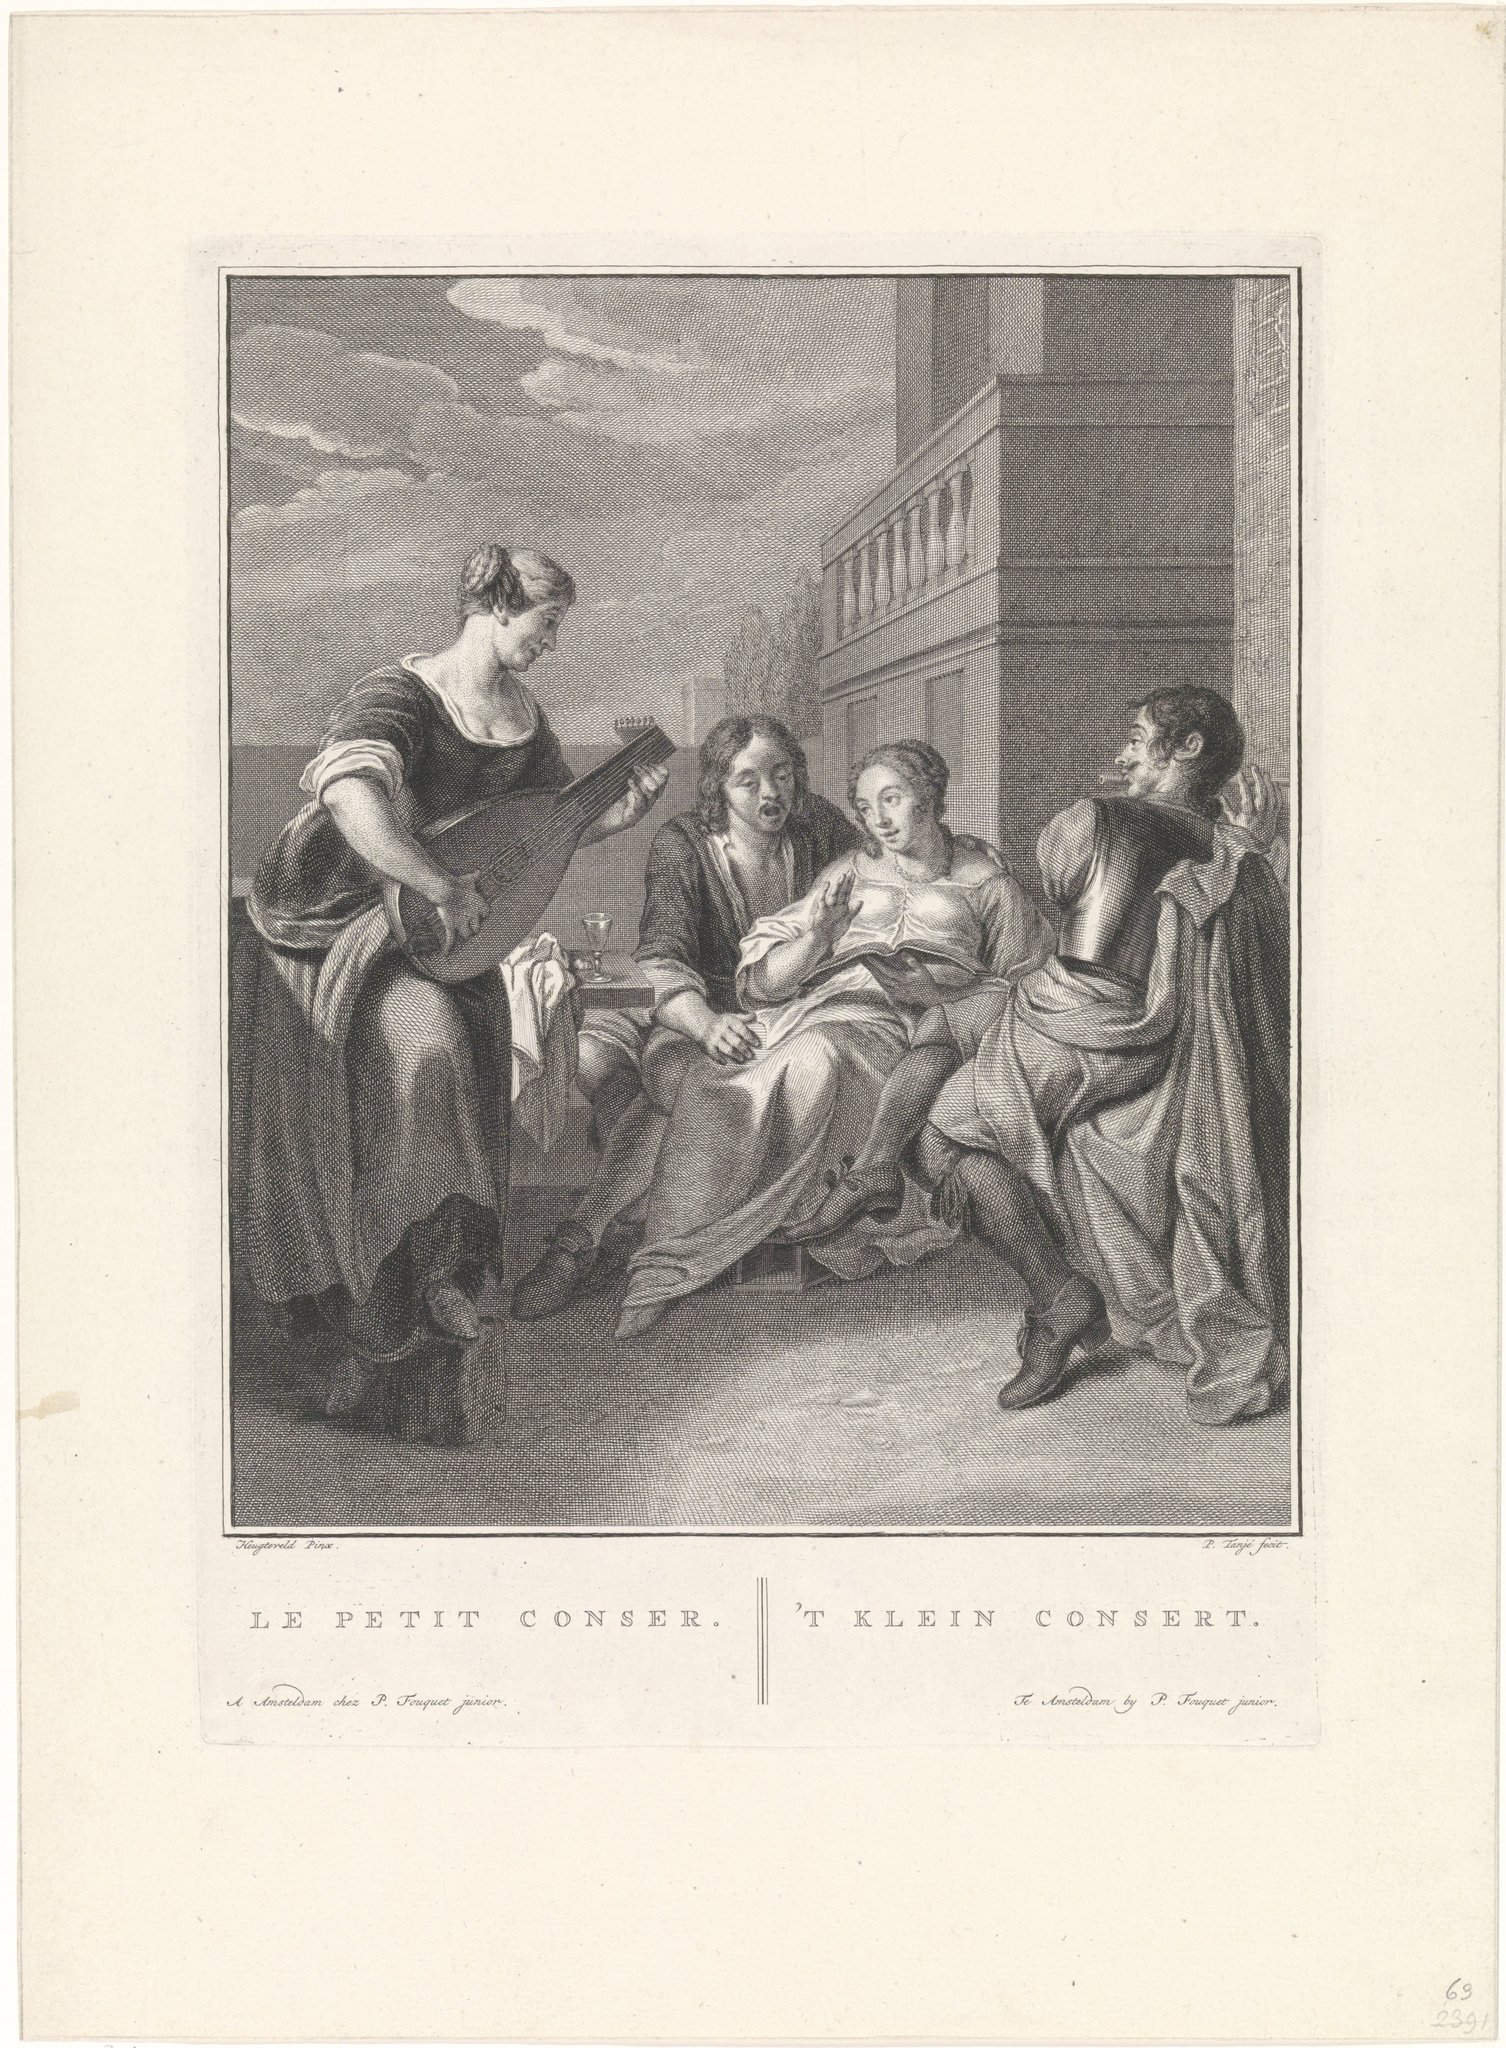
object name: print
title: Le petit conser / 't Klein concert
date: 1760-1761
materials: paper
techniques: engraving, etching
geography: amsterdam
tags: instrumental and vocal music together, transverse flute, lute, and special forms of lute, e.g.: theorbo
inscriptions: collector's mark: Lugt 240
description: Op een terras in de buitenlucht musiceren vier mensen. De vrouw links bespeelt de luit, het stel in het midden zingt en de man rechts bespeelt de dwarsfluit.